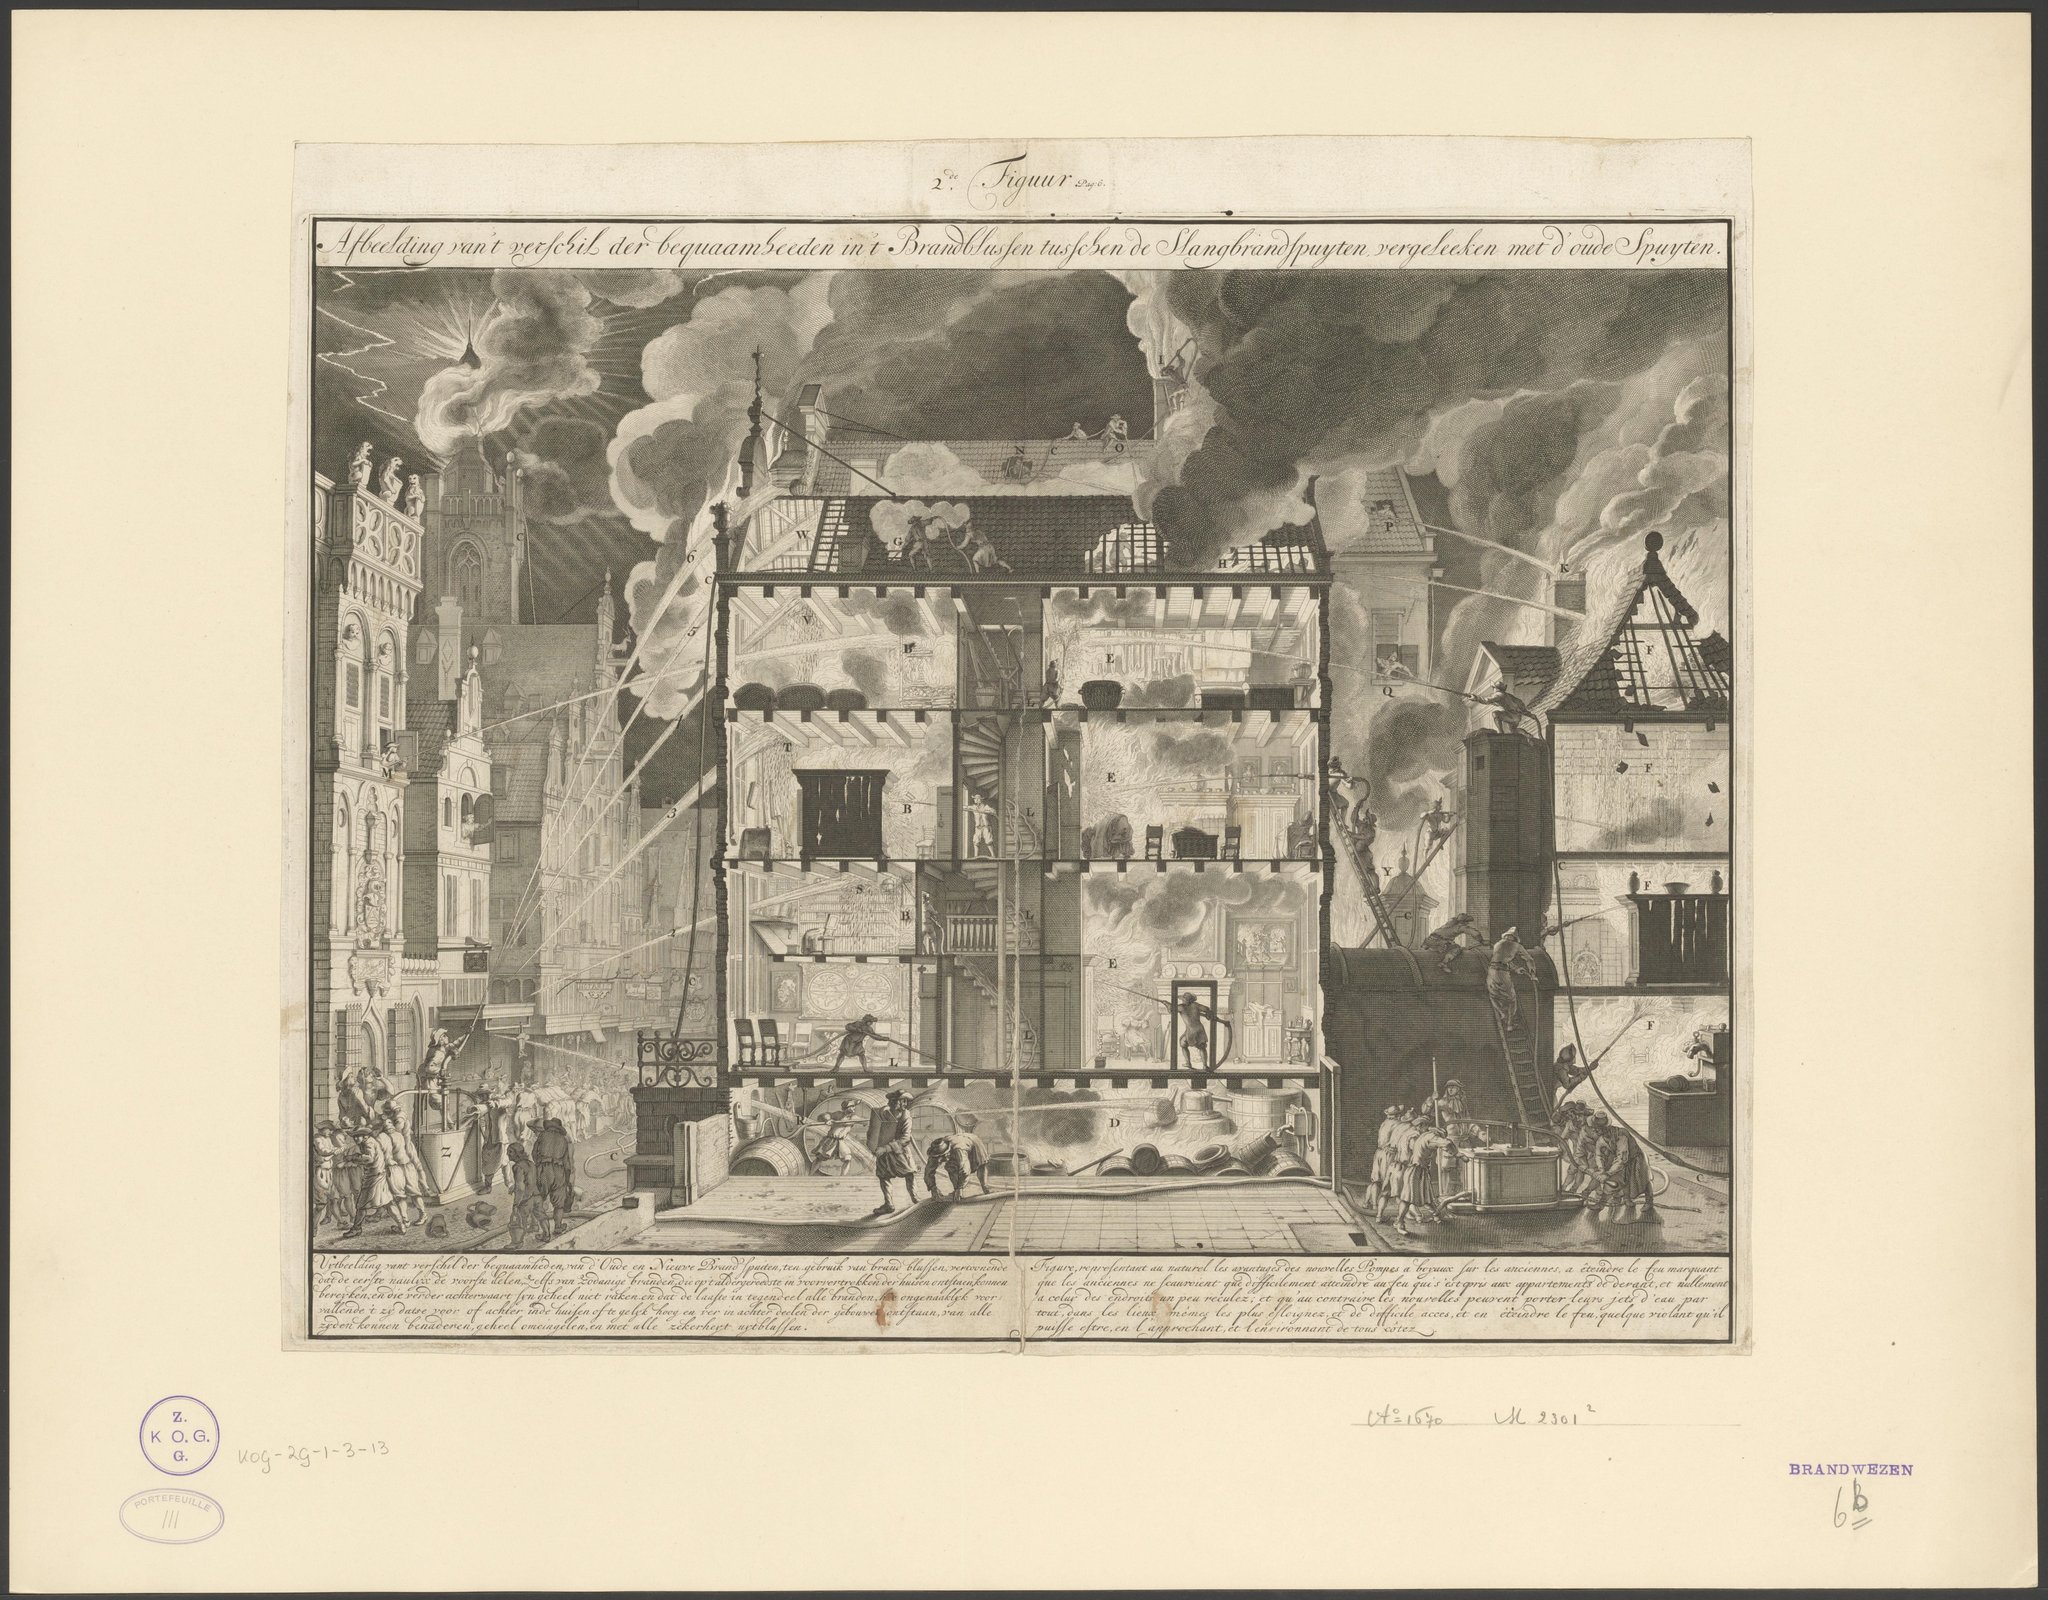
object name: print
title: Afbeelding van 't verschil der bequaamheeden in 't Brandblussen tusschen de Slangbrandspuyten vergeleeken met d'oude Spuyten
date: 1735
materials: paper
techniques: engraving, etching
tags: on fire, ablaze, fire-fighting, fire-extinguishing equipment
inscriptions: stamp, collector's mark: Lugt 1641, stamp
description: Vergelijking tussen de werking en toepassing van oude brandspuiten en de nieuwe slangbrandspuiten bij het blussen van een brand in een huis in de stad. Links de beperkte reikwijdte van de oude spuiten, rechts kunnen de brandweerlieden met de nieuwe lange slagen het huis binnengaan en de brandhaarden ter plekke bestrijden. Met onderschrift in Nederlands en Frans. Bovenaan de tekst: 2de Figuur Pag: 6. Onderwerpsrubrieken binnen de Atlas Zeden en Gewoonten: Regeering, Brandwezen.